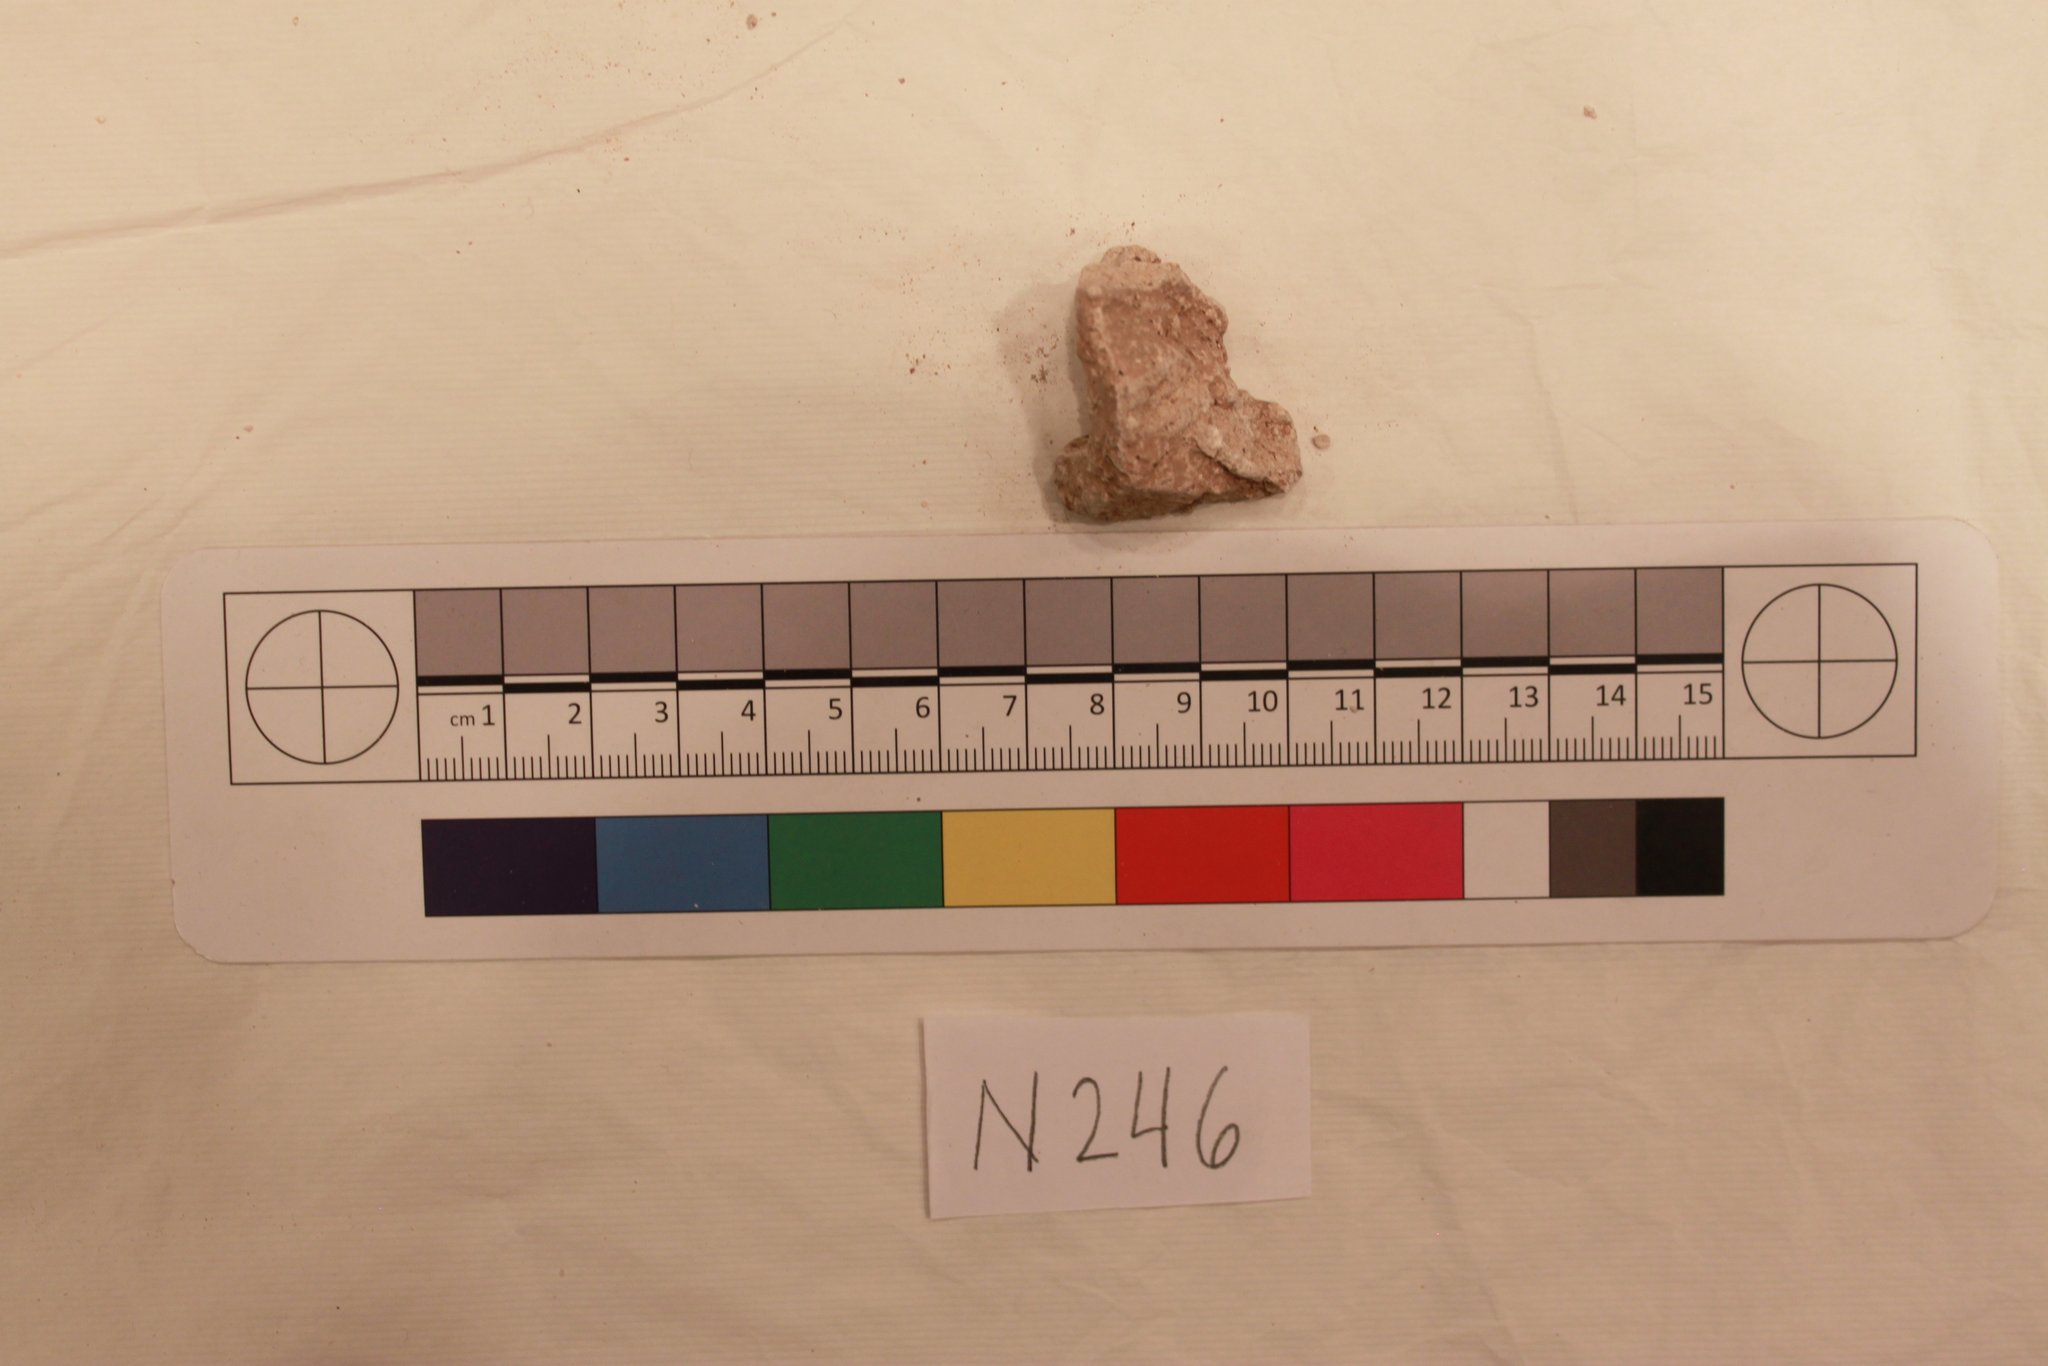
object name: fragment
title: Stucco Fragment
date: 701-1200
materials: plaster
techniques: carving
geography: iran